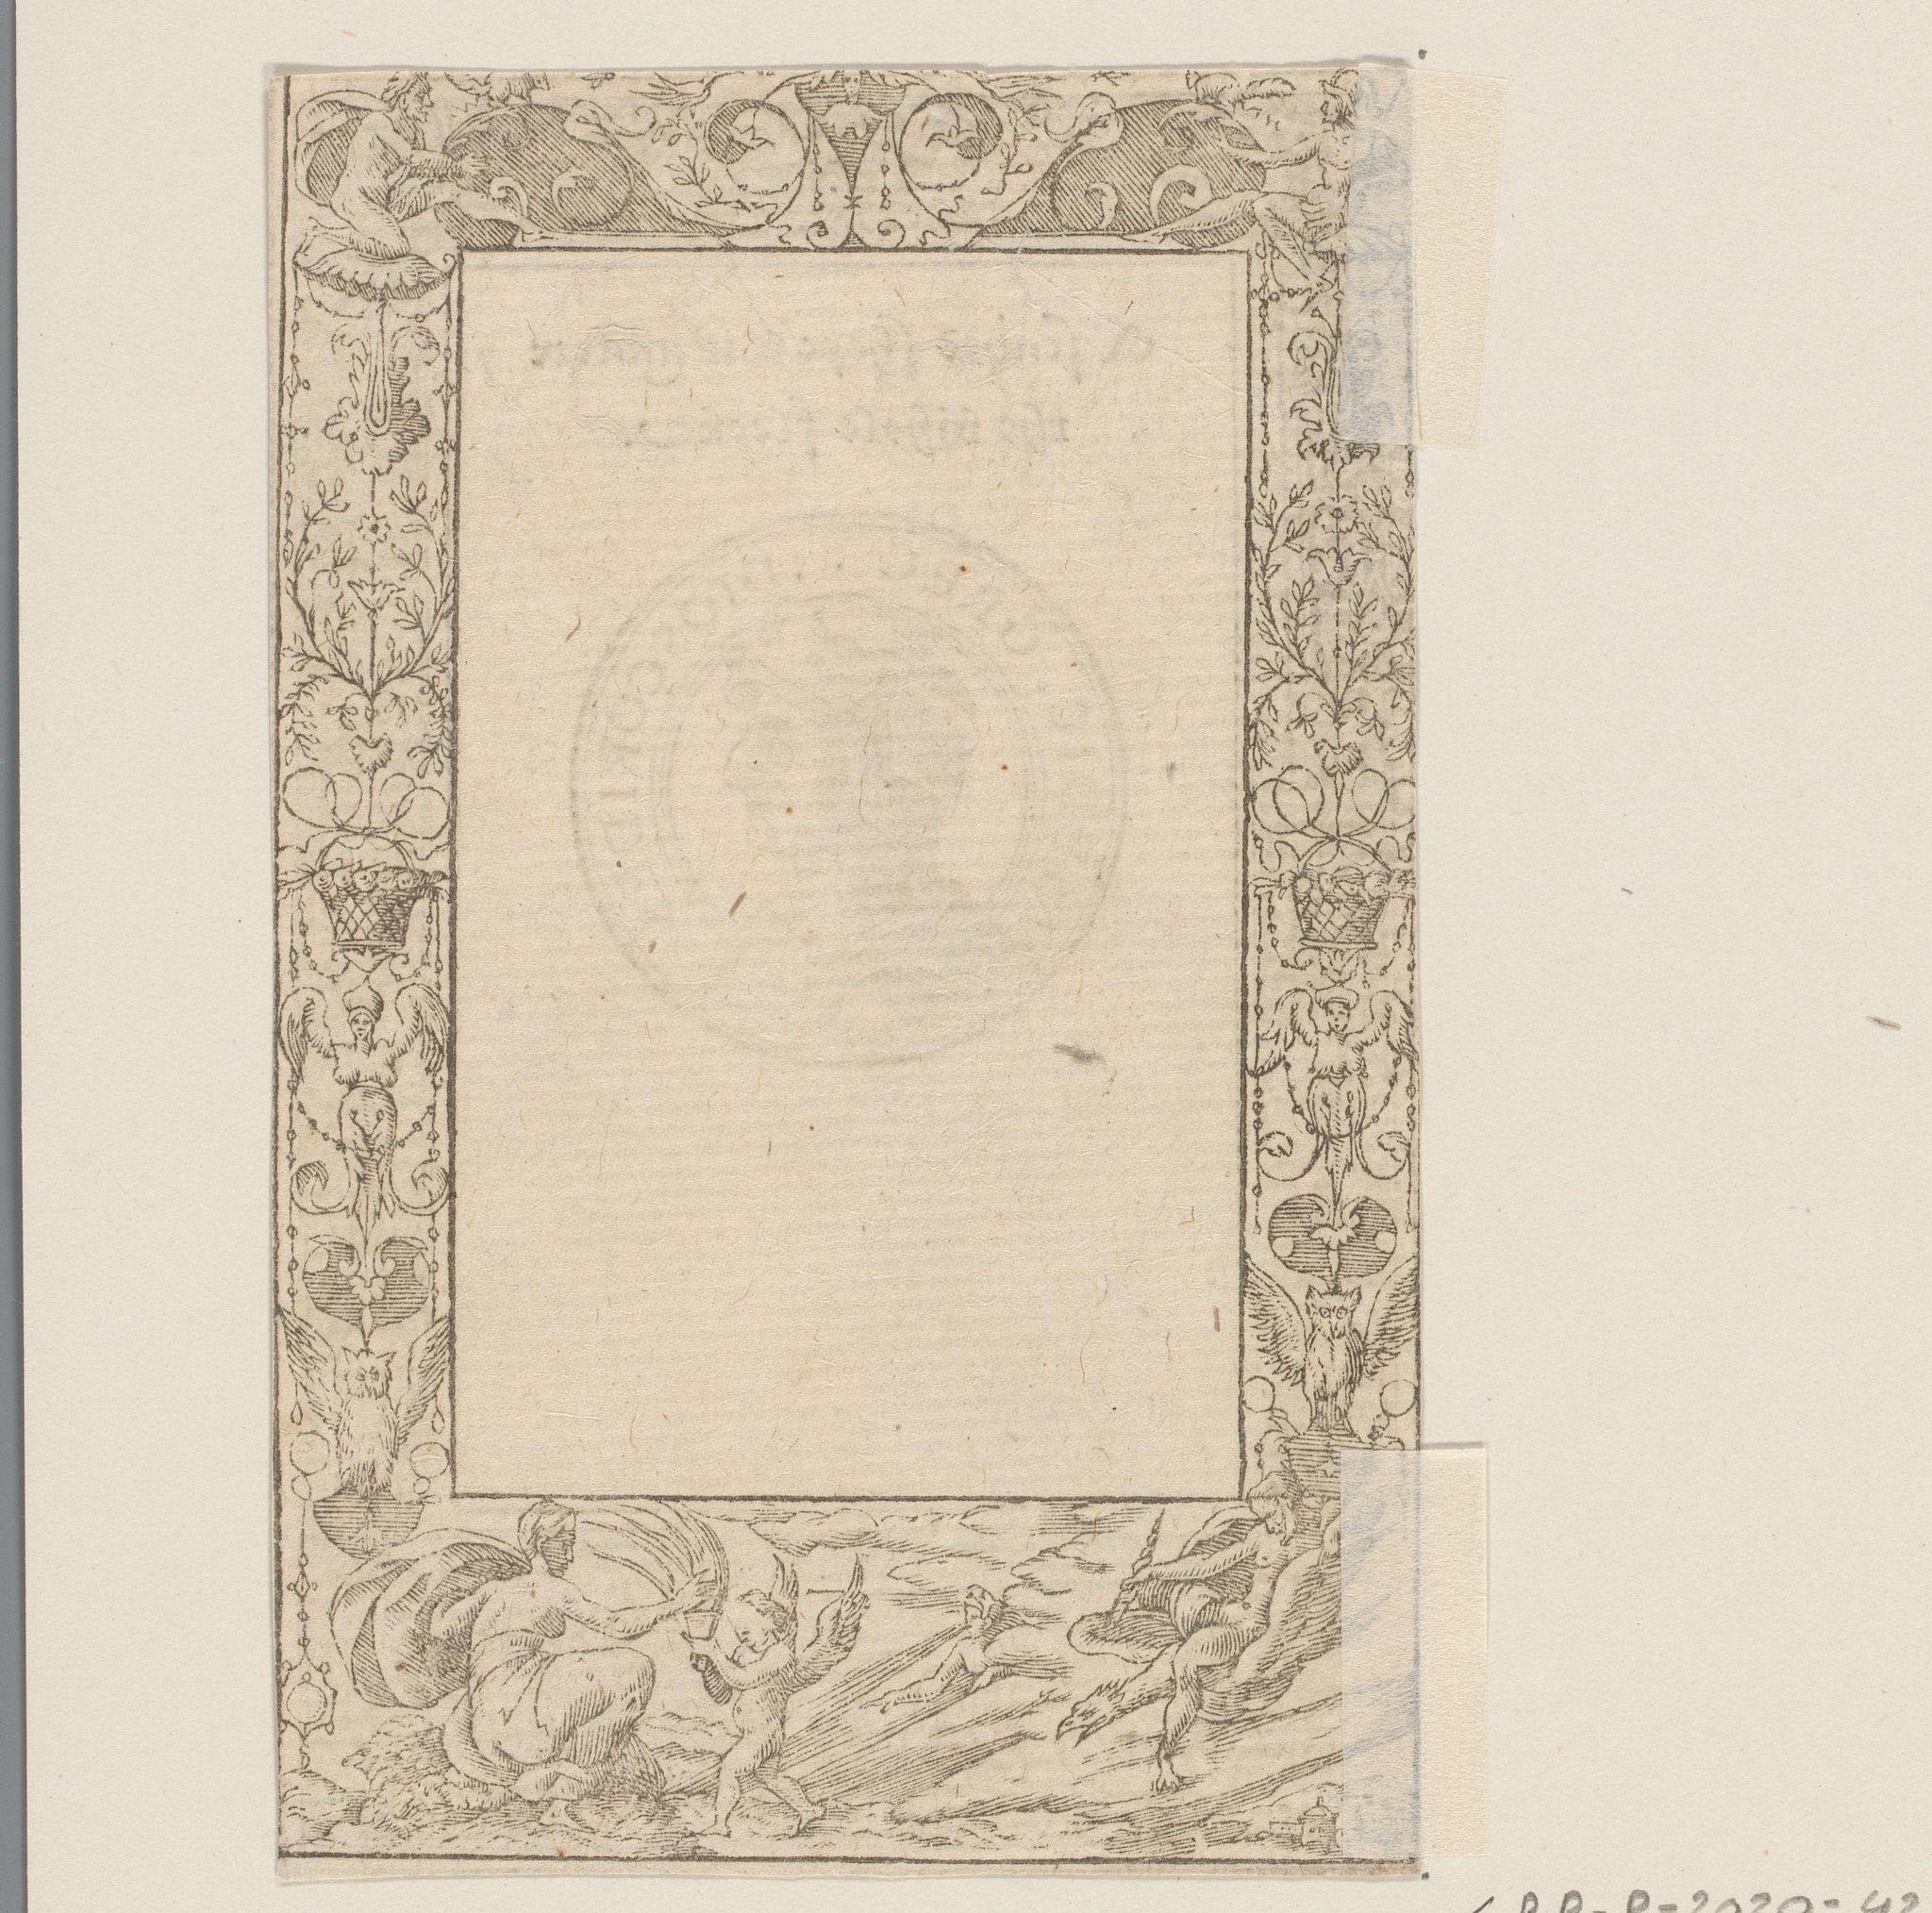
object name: print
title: Omlijsting met grotesken en Amor die een fakkel draagt.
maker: Anonymous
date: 1550-1650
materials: paper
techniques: woodcut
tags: ornament ~ grotesque, (story of) jupiter (zeus), (story of) cupid, amor (eros), gods of the winds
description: Amor brengt een fakkel naar een zittende vrouw. Rechts van hem blaast een windgod en zit een man, mogelijk Jupiter, op een wolk.